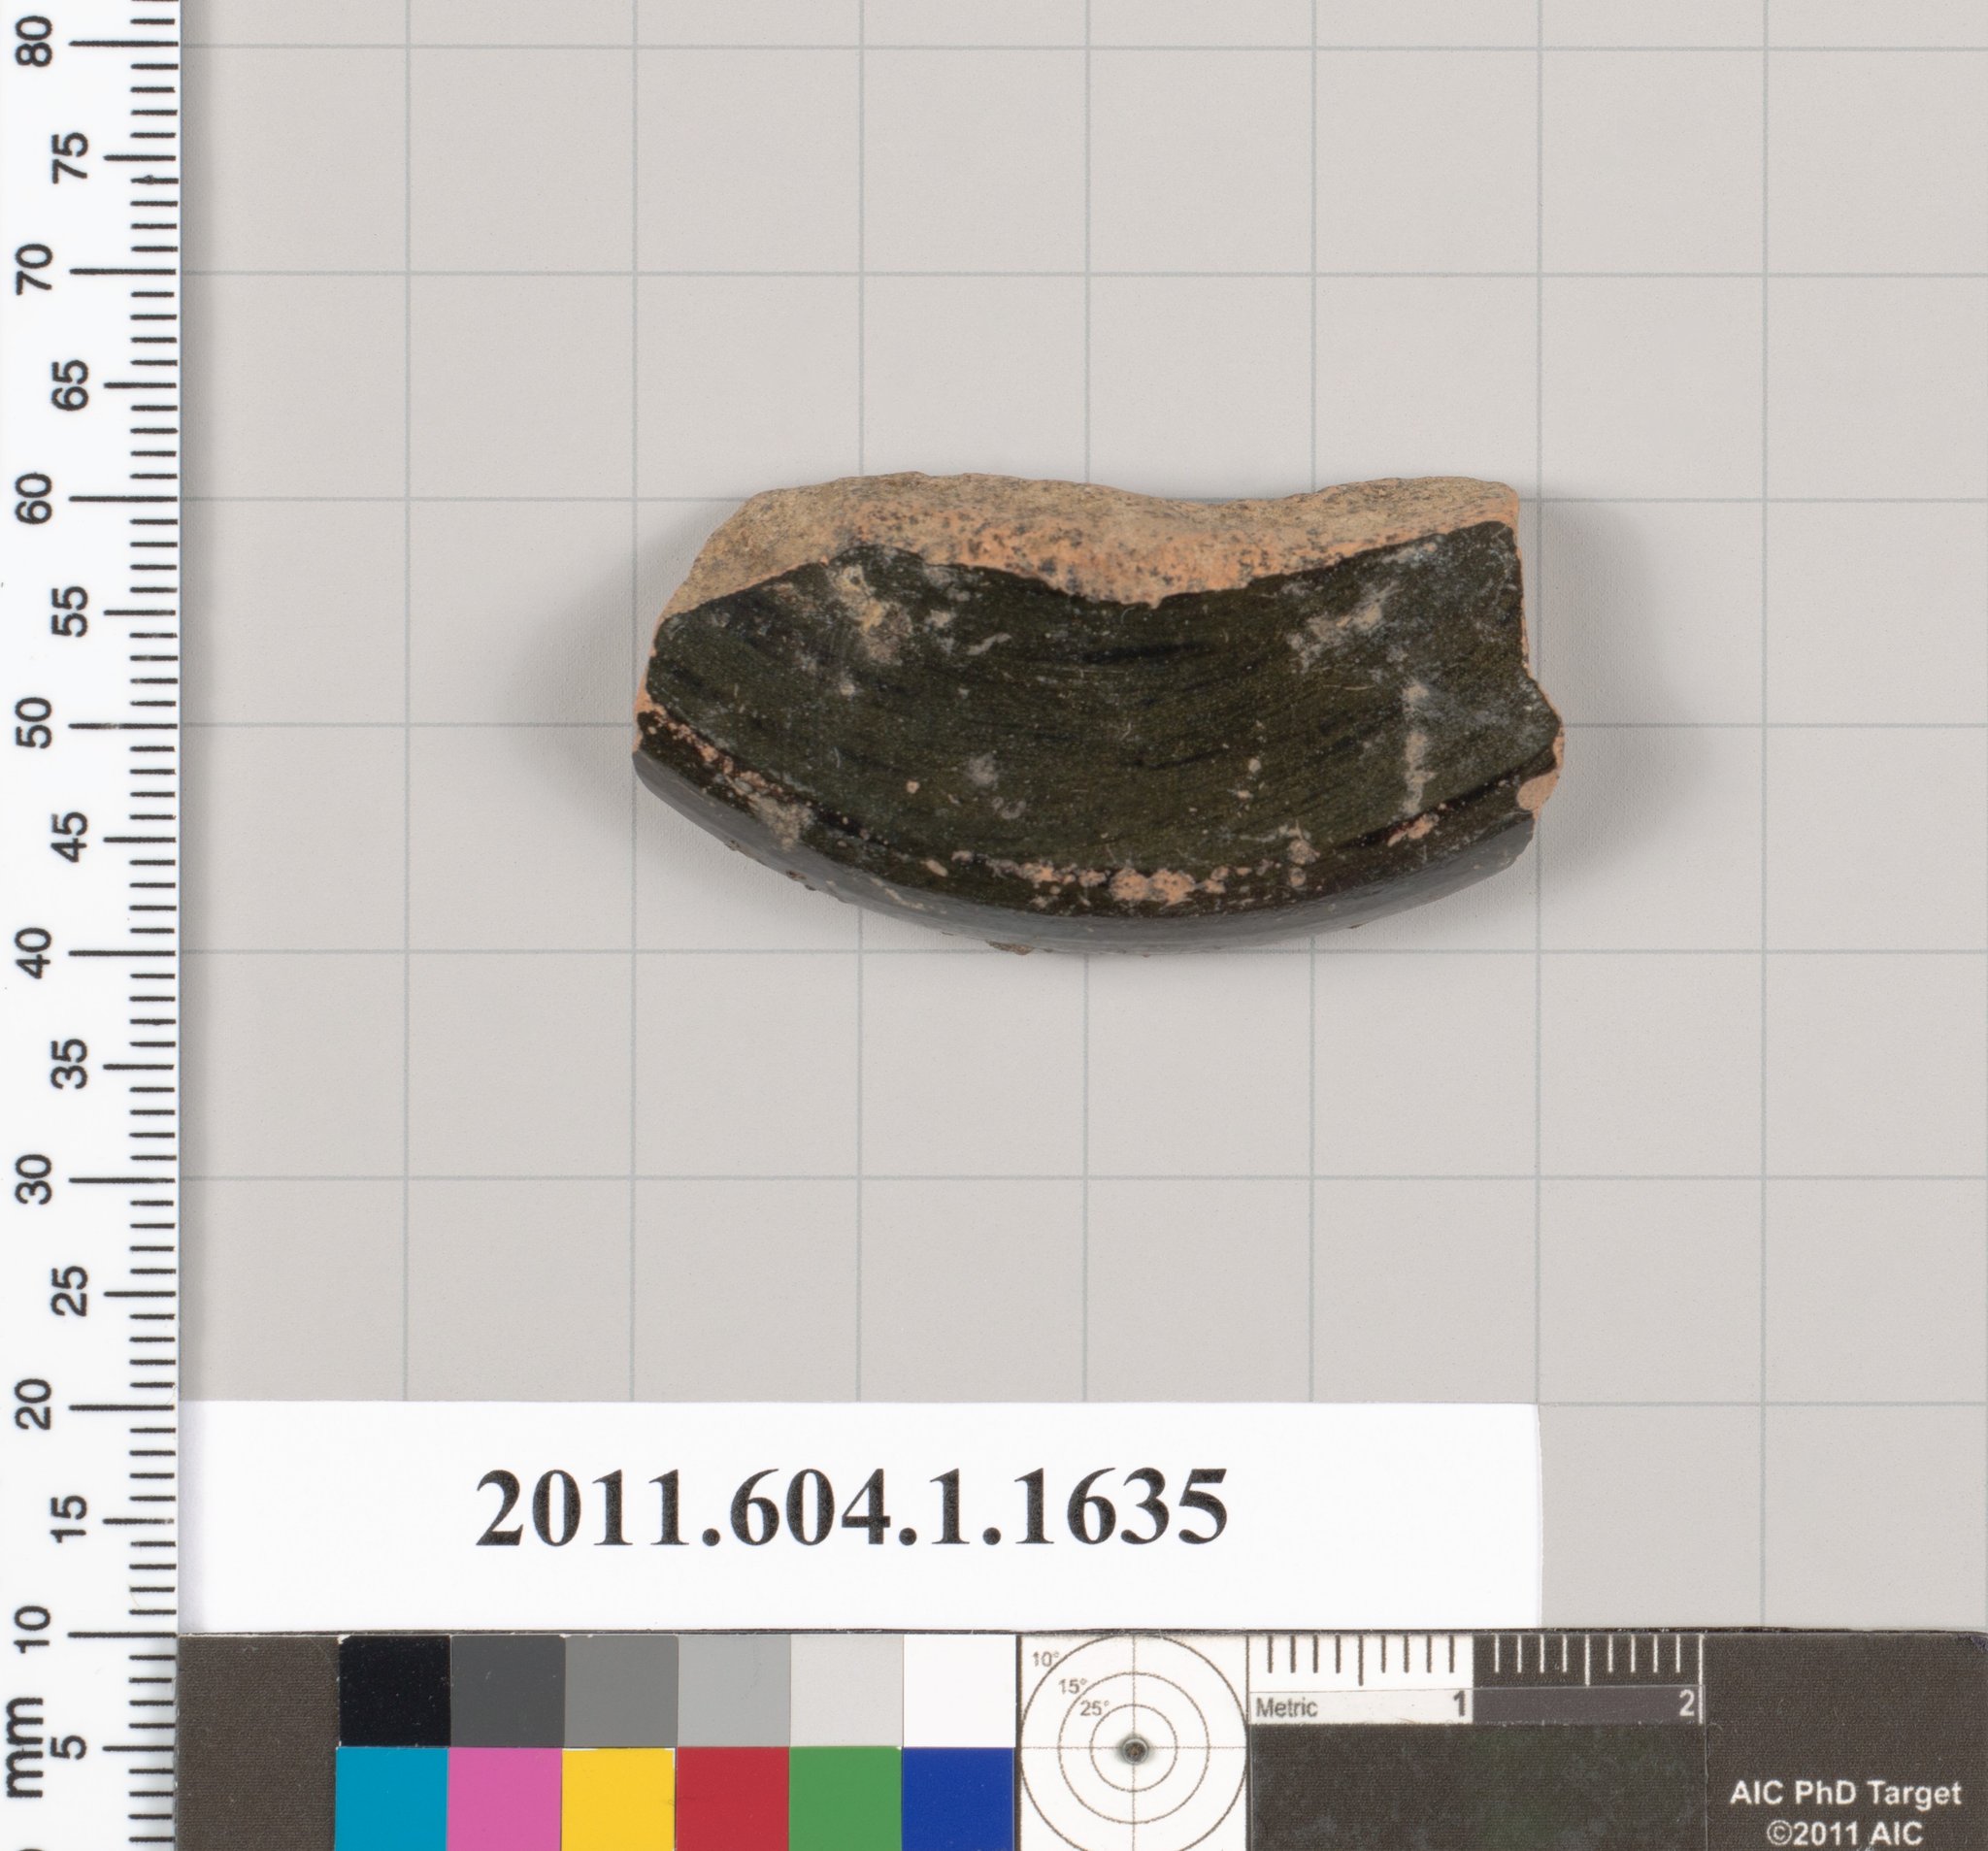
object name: kylix fragment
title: Terracotta fragment of a kylix (drinking cup)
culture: greek, attic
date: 500-401 BCE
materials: terracotta